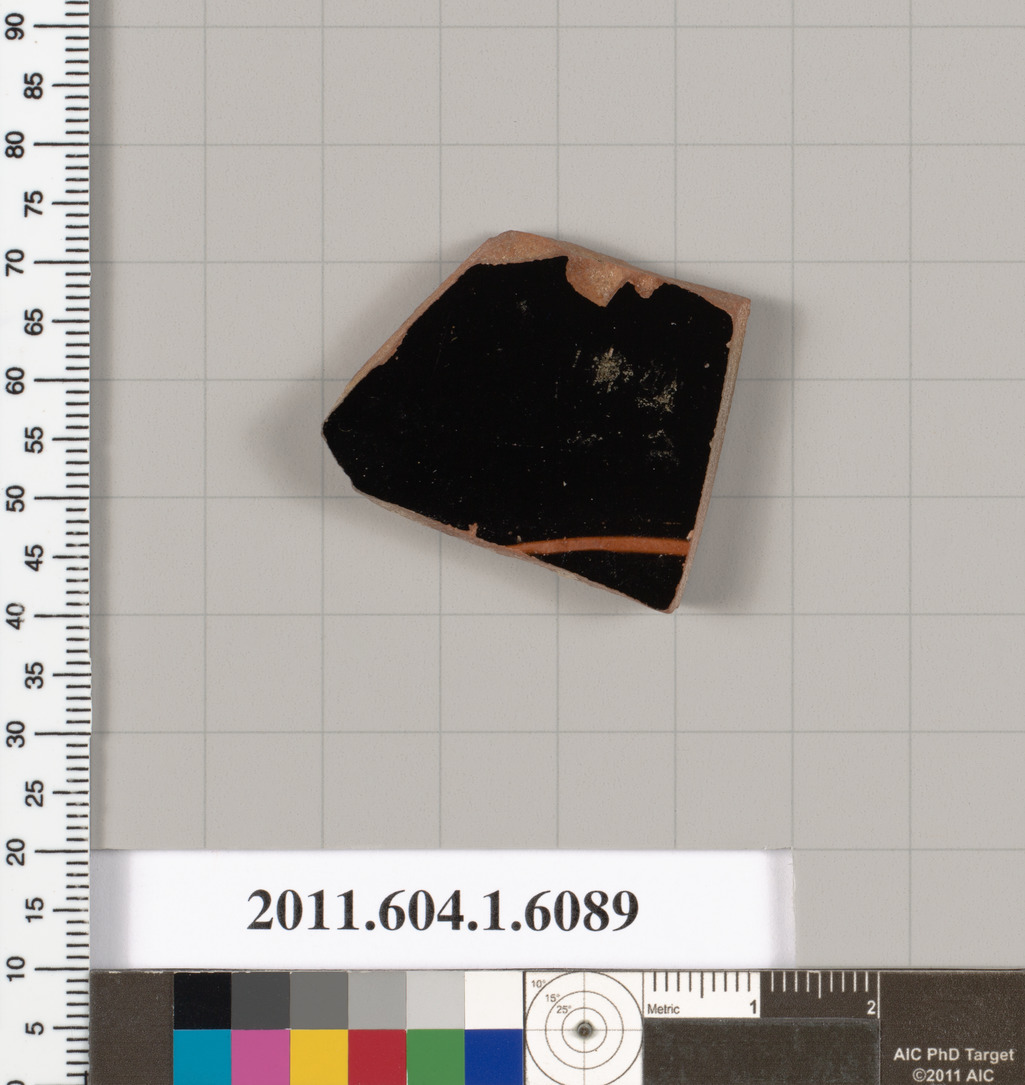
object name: kylix fragment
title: Terracotta fragment of a kylix (drinking cup)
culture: greek, attic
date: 500-490 BCE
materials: terracotta